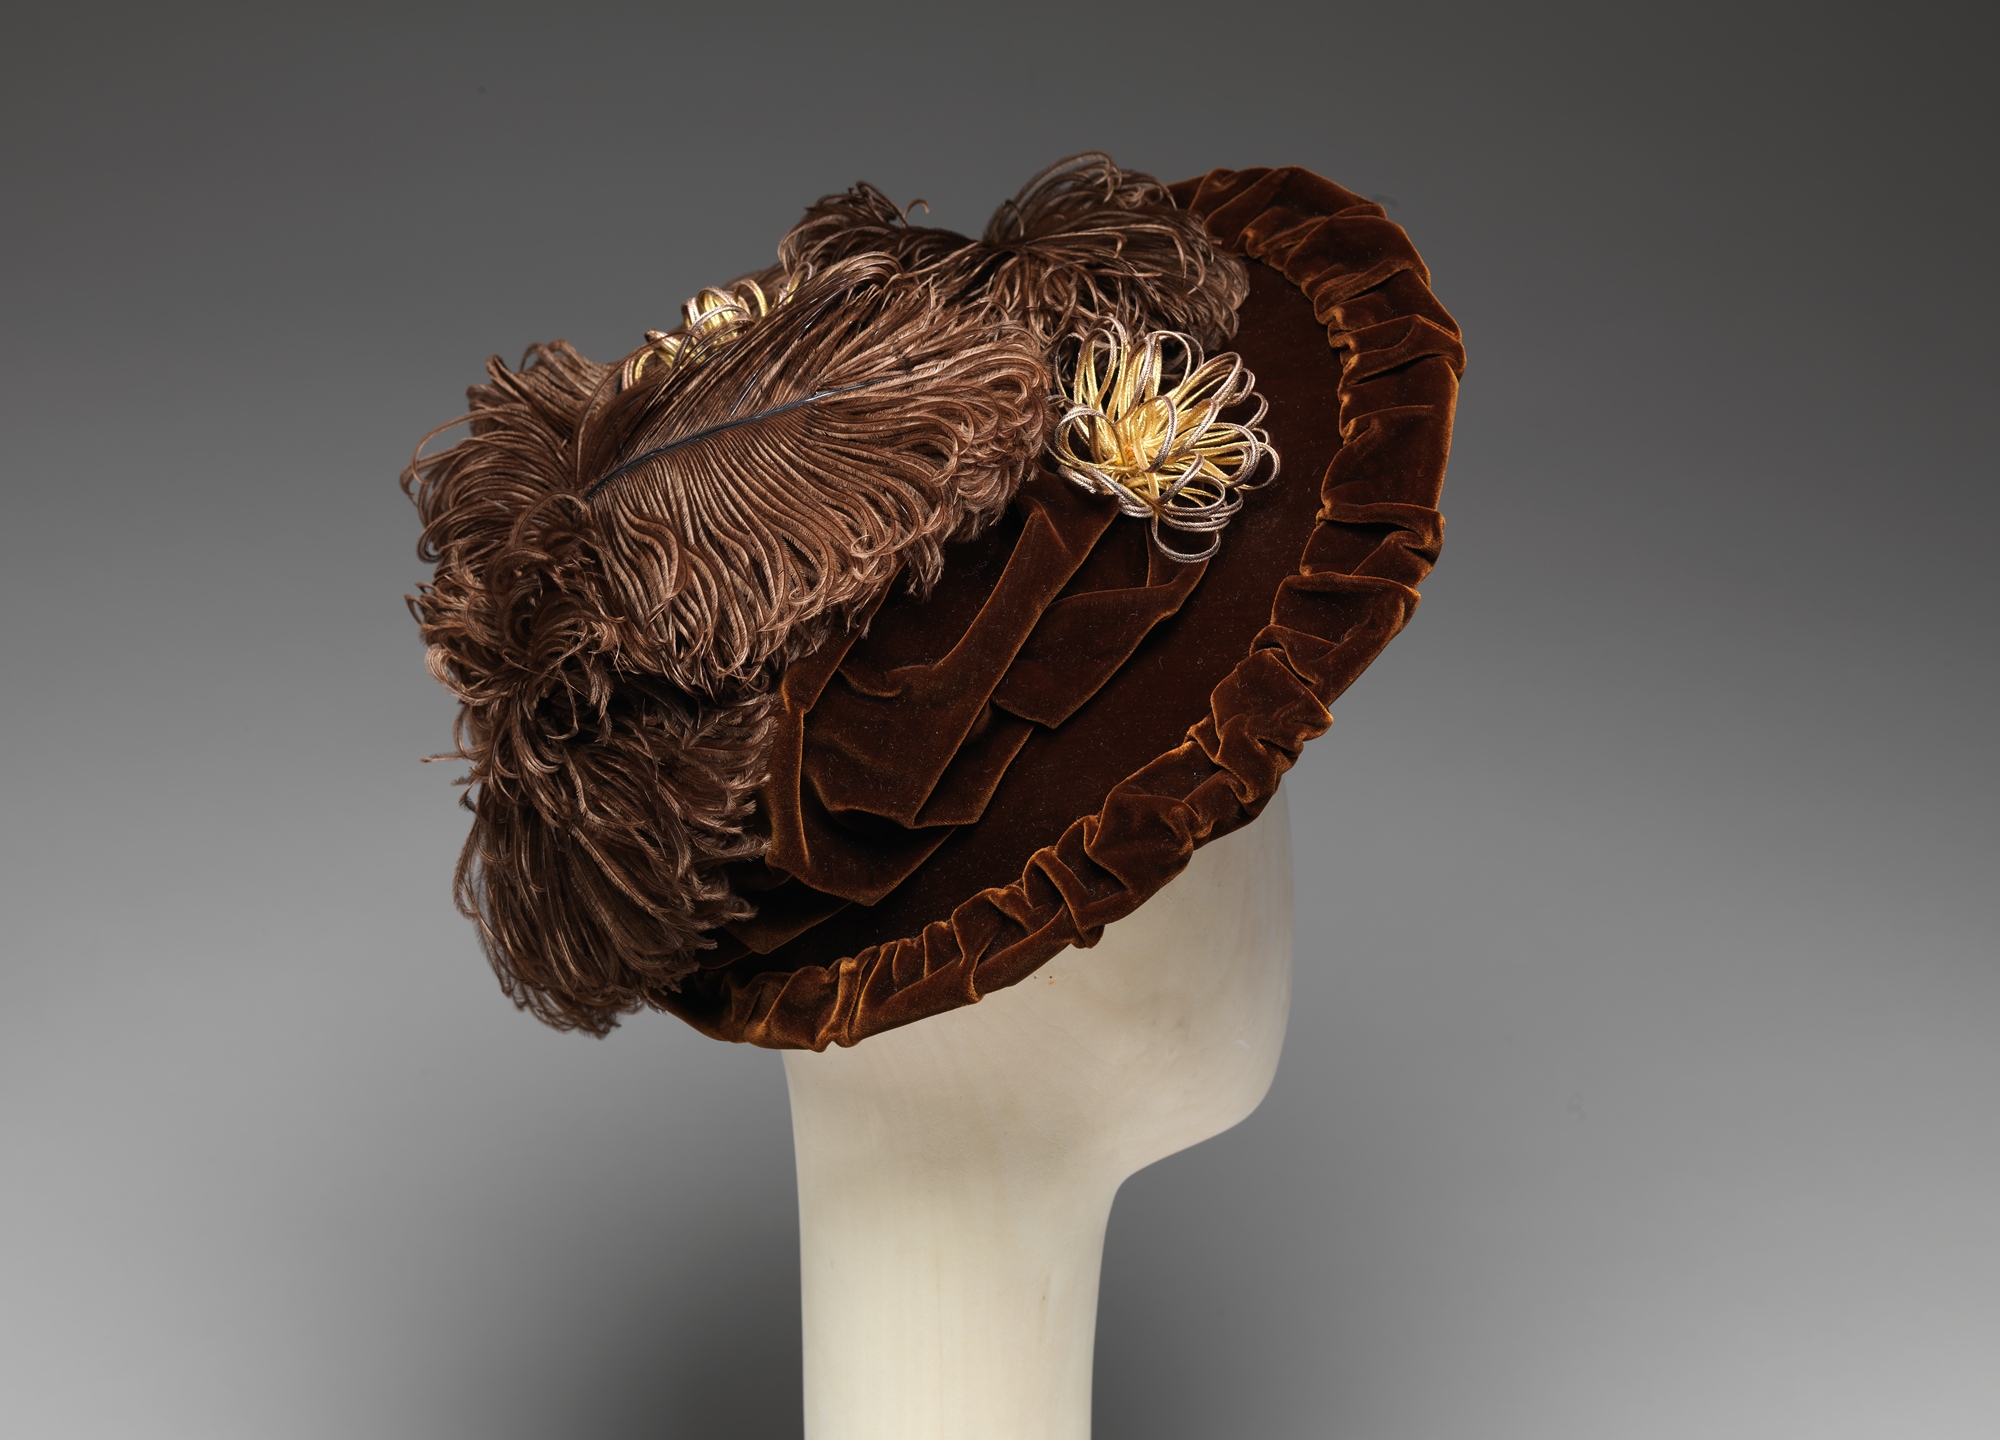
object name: hat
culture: french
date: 1887